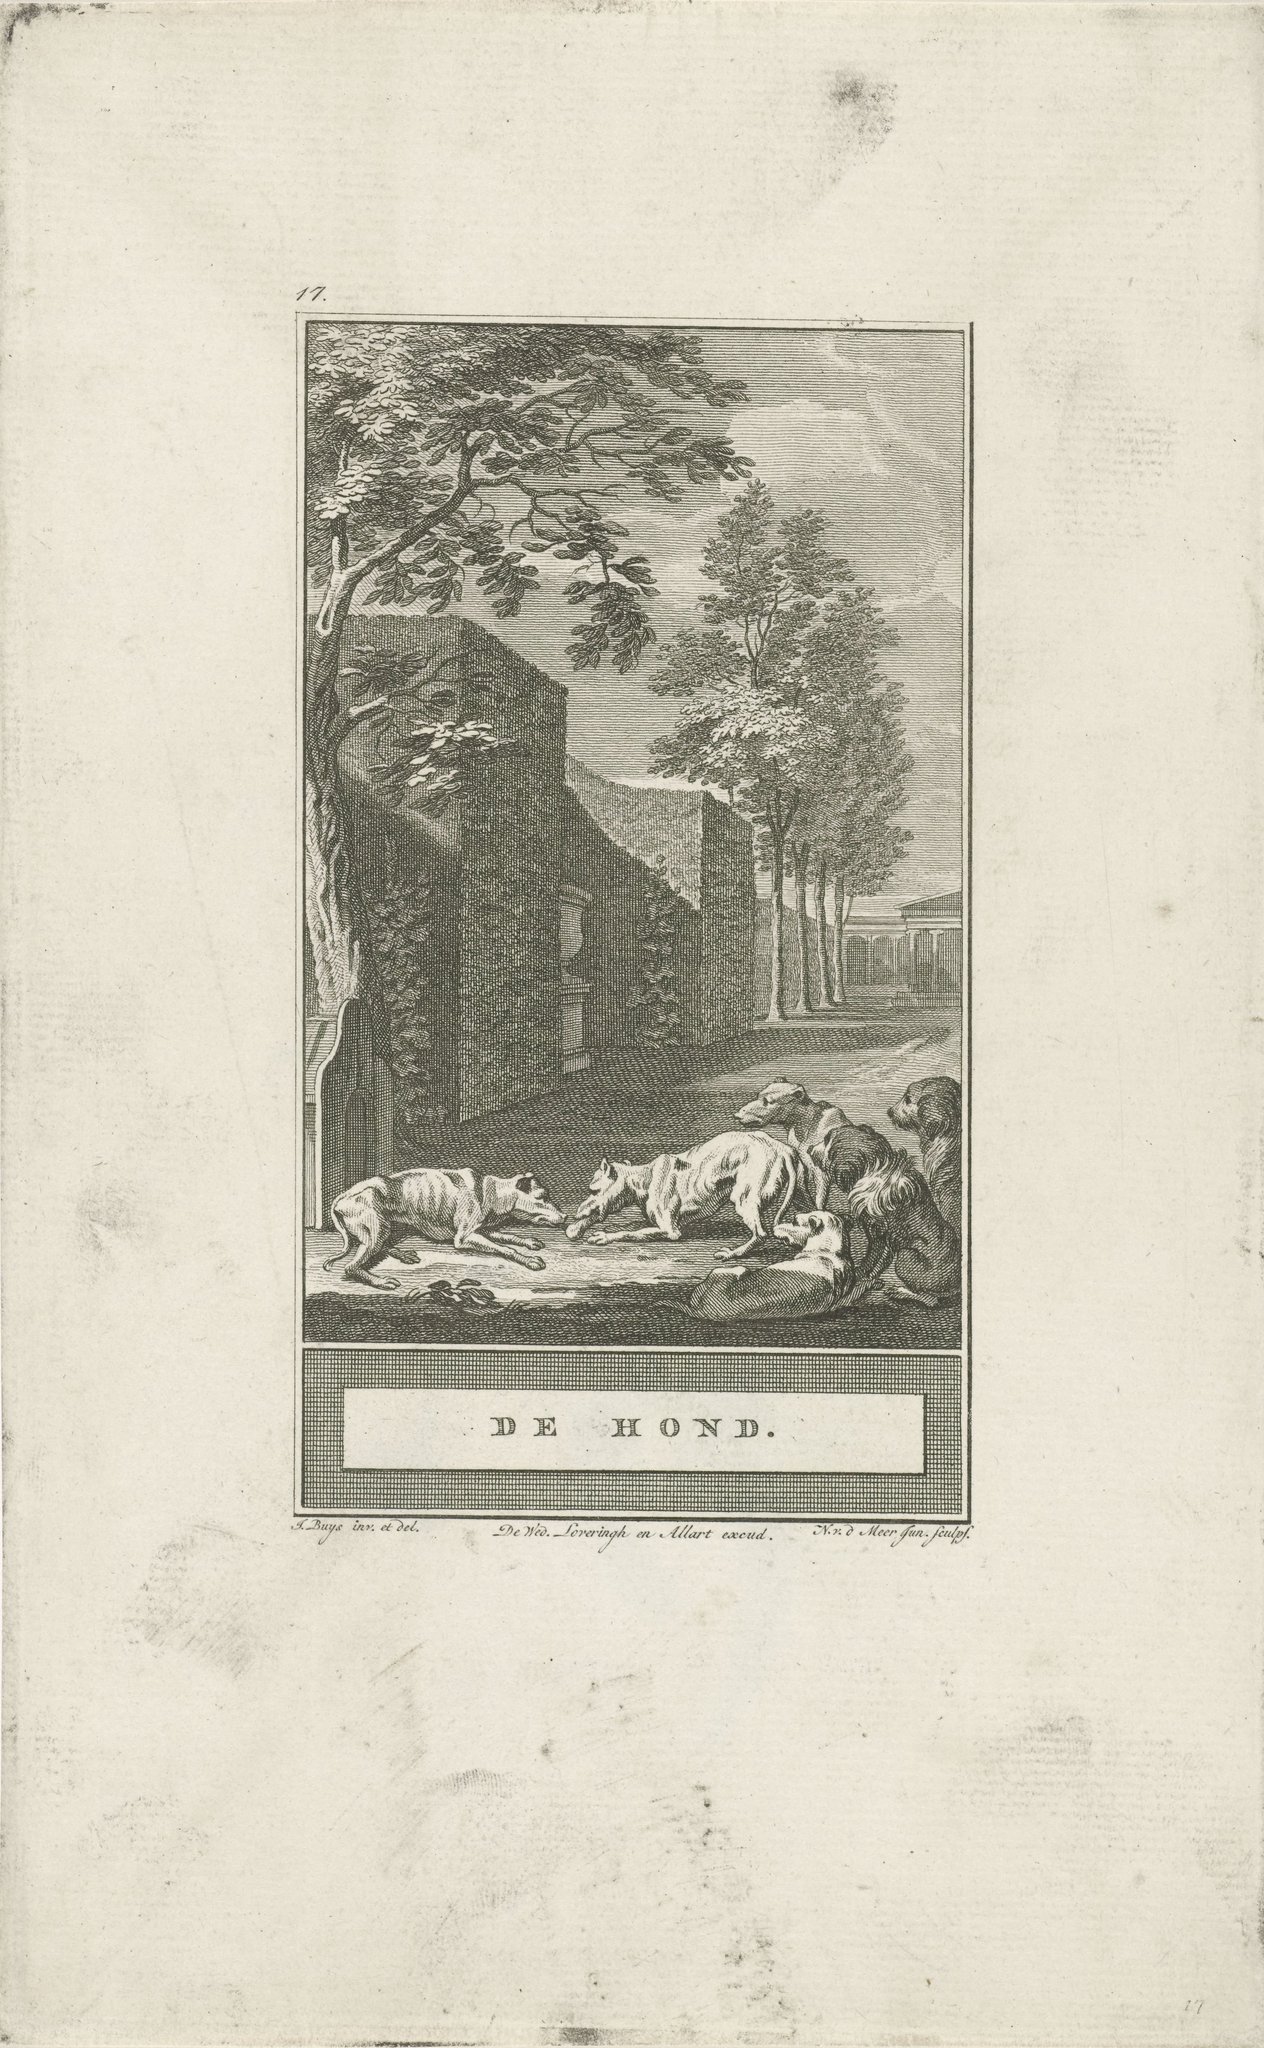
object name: book illustration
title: De hond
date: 1777-1778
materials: paper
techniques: etching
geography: amsterdam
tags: garden, dog with bone, dog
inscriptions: collector's mark: Lugt 2228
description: Prent bij: Gellert, Christian Fürchtegott. Fabelen en vertelsels. 3 dln. Amsterdam: Pieter Meyer, 1772-1774. De prenten bij deze publicatie werden later uitgegeven. De exemplaren uitgegeven door de weduwe Jacobus Loveringh & Johannes Allart tussen 1777 en 1778, de exemplaren uitgegeven door alleen Johannes Allart tussen 1778 en 1785.